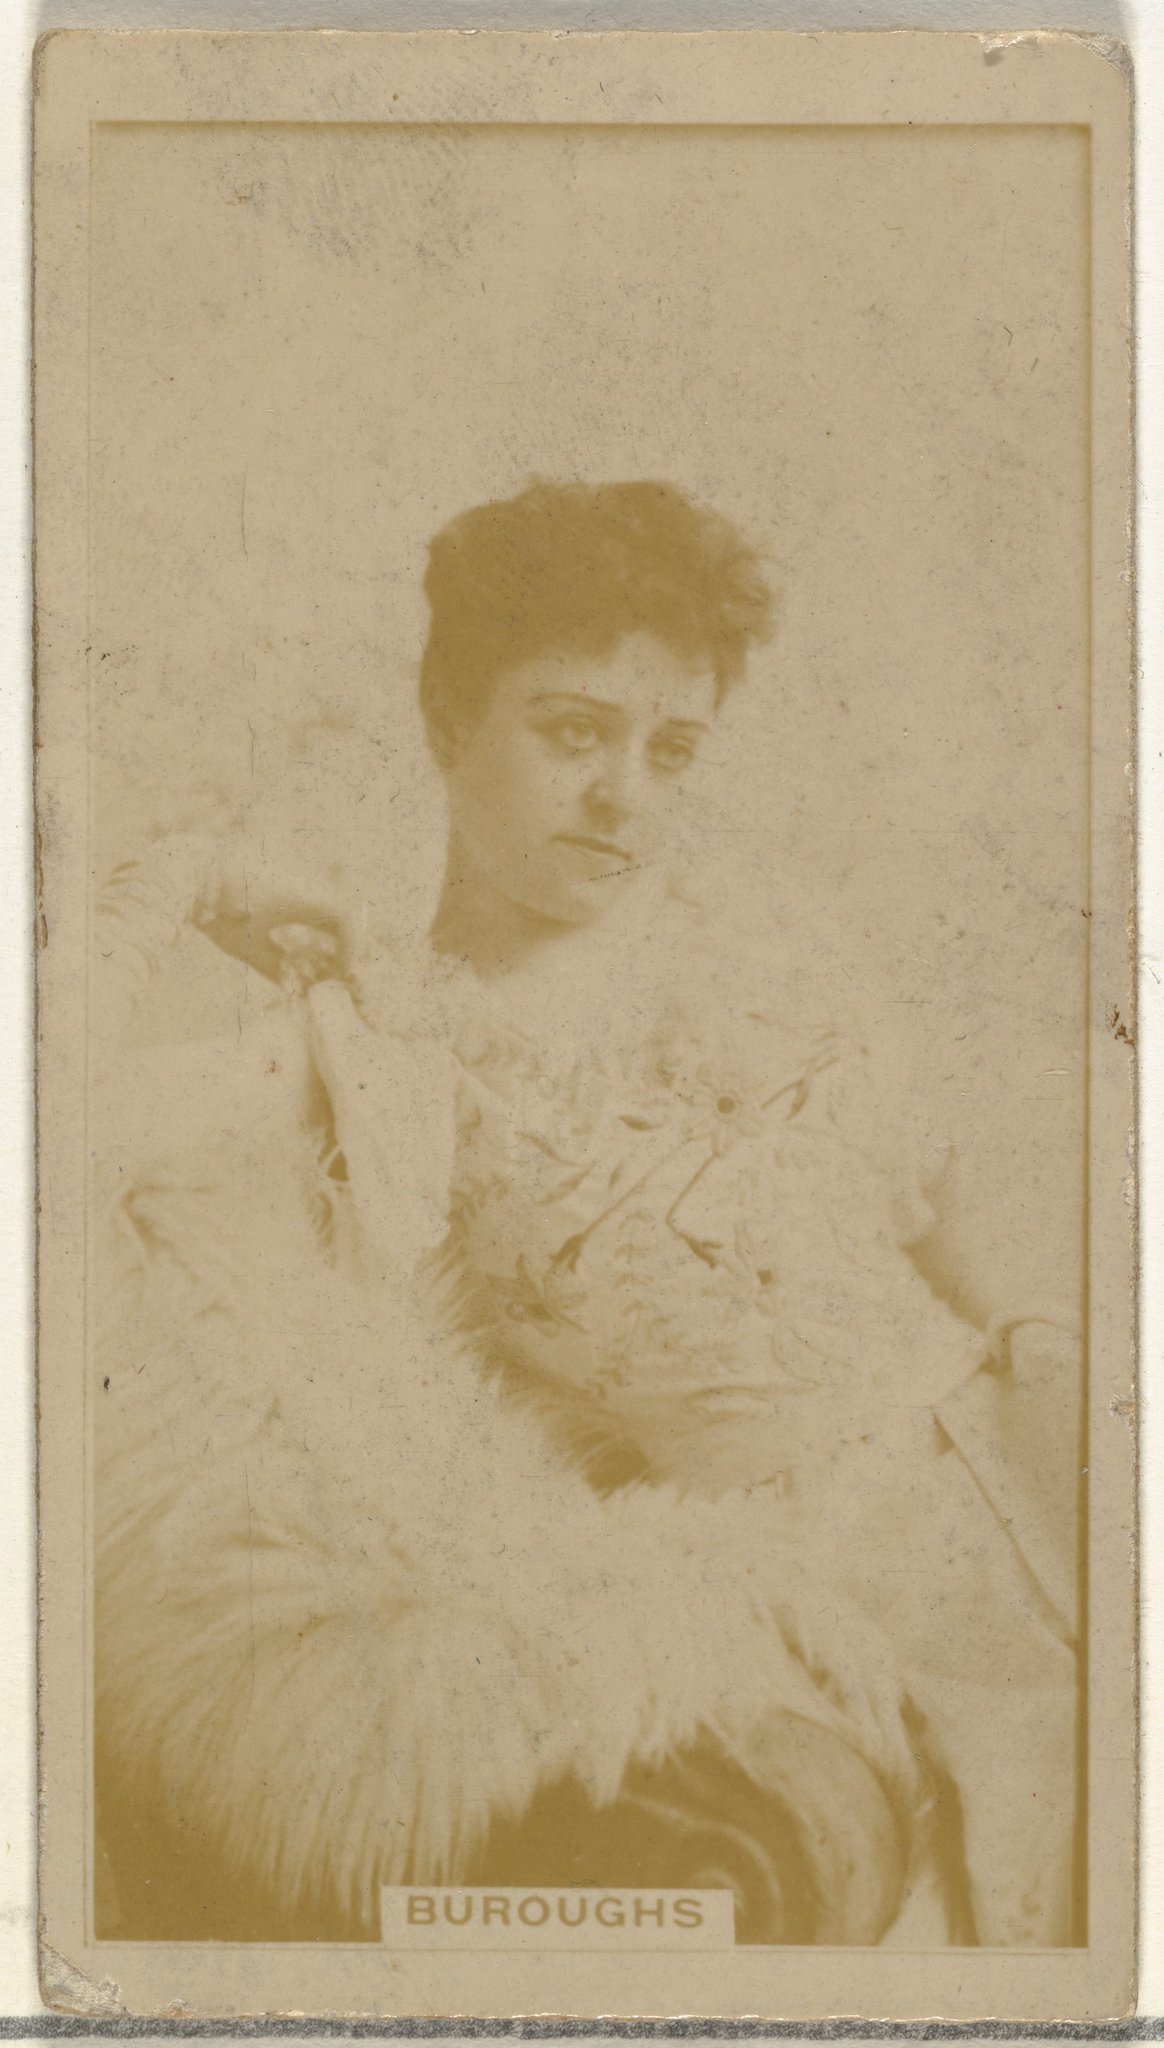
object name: photograph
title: Miss Buroughs, from the Actors and Actresses series (N145-8) issued by Duke Sons & Co. to promote Duke Cigarettes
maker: w. duke, sons & co.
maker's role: publisher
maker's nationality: american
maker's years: 1870-1920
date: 1891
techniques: albumen silver print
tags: portraits,women,actresses